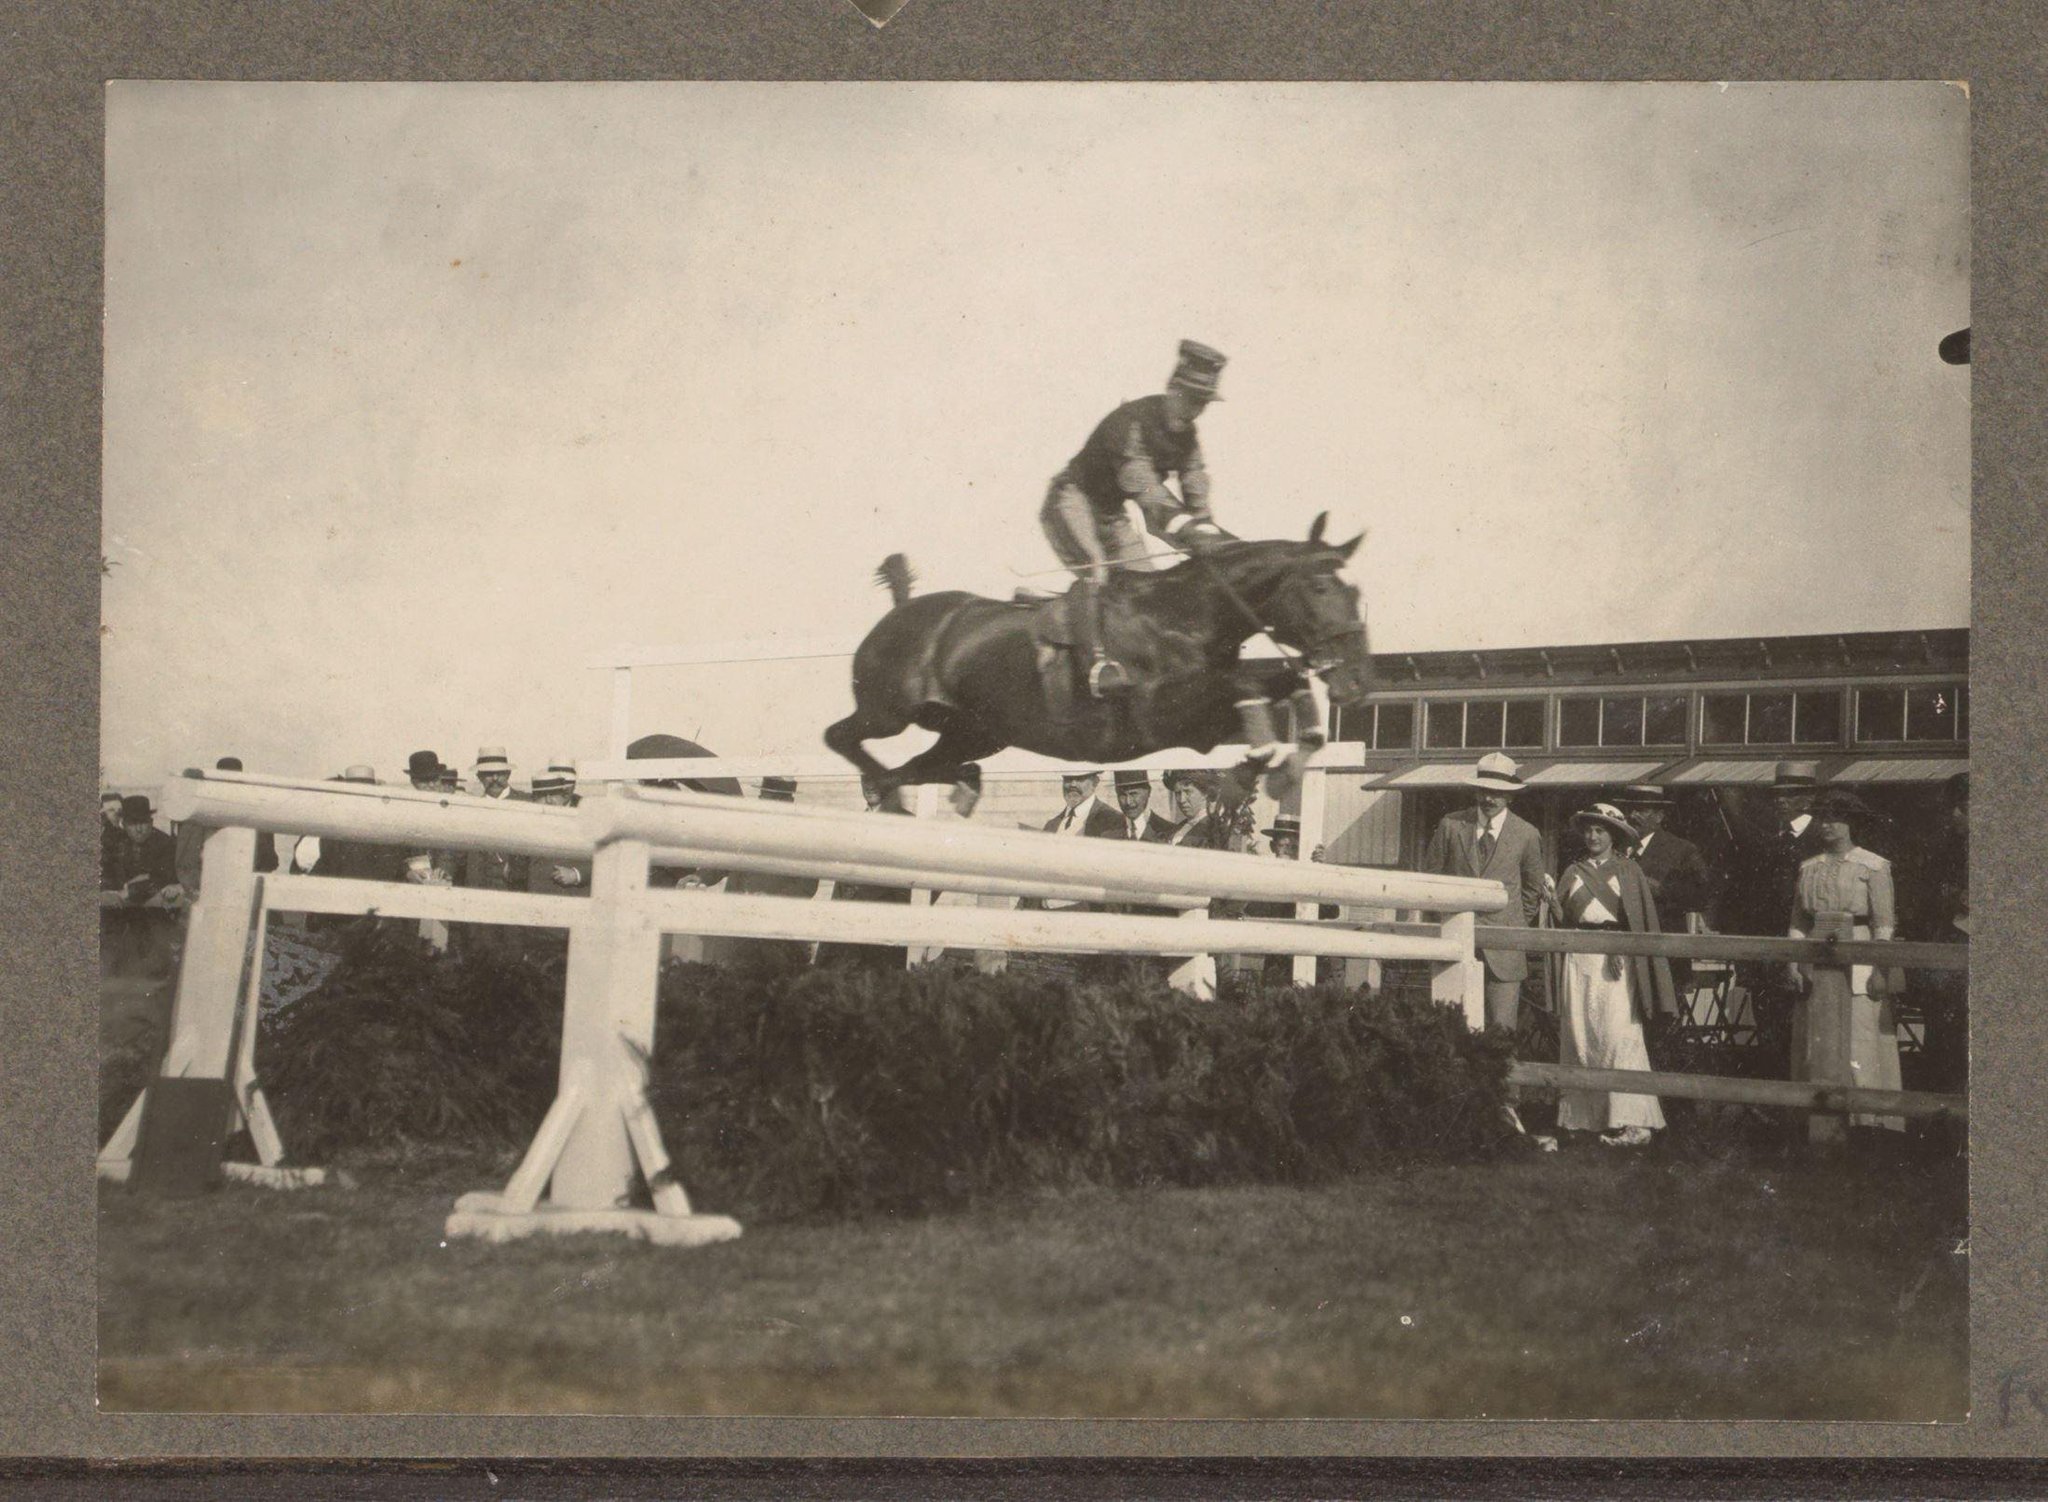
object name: photograph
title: Ruitertafereel op Koninklijke Houtvesterij Het Loo: geüniformeerde ruiter neemt hindernis op een renbaan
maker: Anonymous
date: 1900-1925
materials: photographic support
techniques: gelatin silver print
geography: het loo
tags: riding a horse, ass, or mule; rider, horseman, hunting, chase, hunting-ground, horse-racing, jumping (horse in motion), (military) uniforms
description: Onderdeel van Fotoalbum van de heer Brams, opperhoutvester van koningin Wilhelmina op Koninklijke Houtvesterij Het Loo.